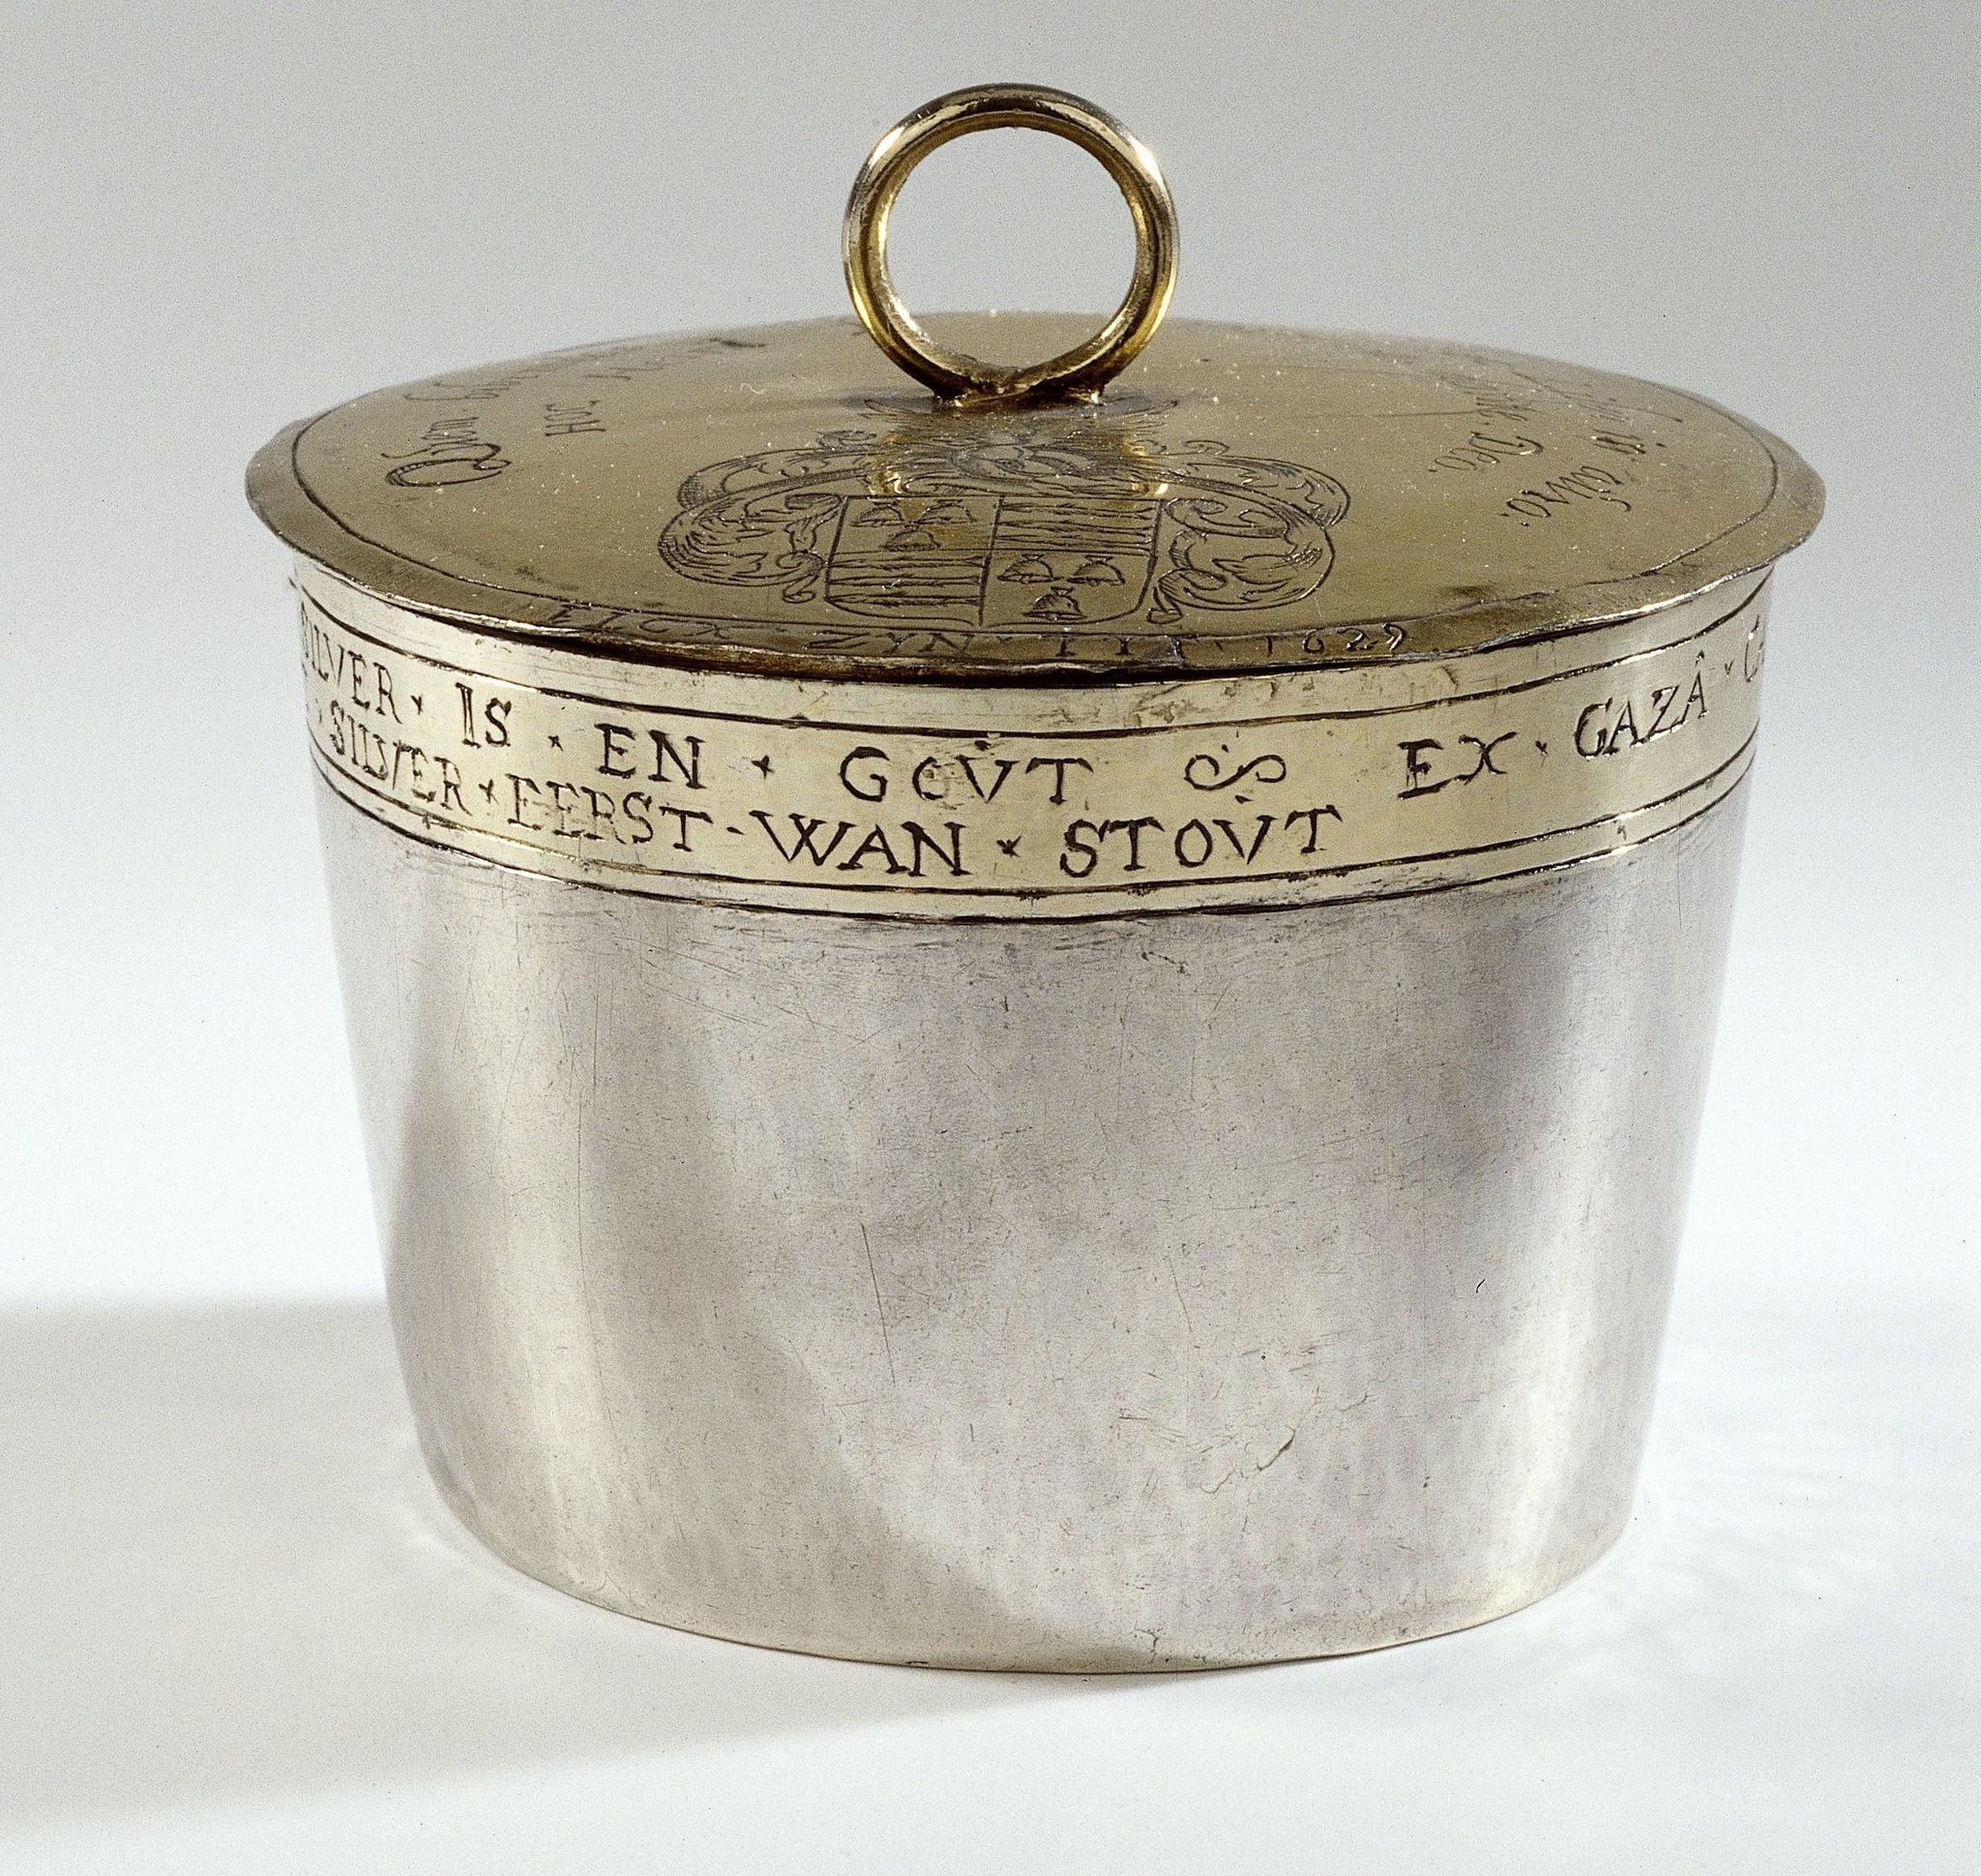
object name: wijnkroes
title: Three Wine Cups Made with Booty from the Silver Fleet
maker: roelant gerobulus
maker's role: goldsmith, silversmith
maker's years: -1632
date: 1629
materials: silver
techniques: engraving, forging, gilding, striking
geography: utrecht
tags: duinkerke, luitenant-admiraal, piet hein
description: This set of matching, nesting wine cups was made to honour Piet Heinâ€™s victory over the Spanish Treasure (or Silver) Fleet in 1628. This remarkable event is commemorated in the engraved text, which describes how the drinking vessels were fashioned from confiscated precious metal. The coat-of-arms of the commissioner, probably a member of the Sweers family, is engraved on the bottoms and lids.